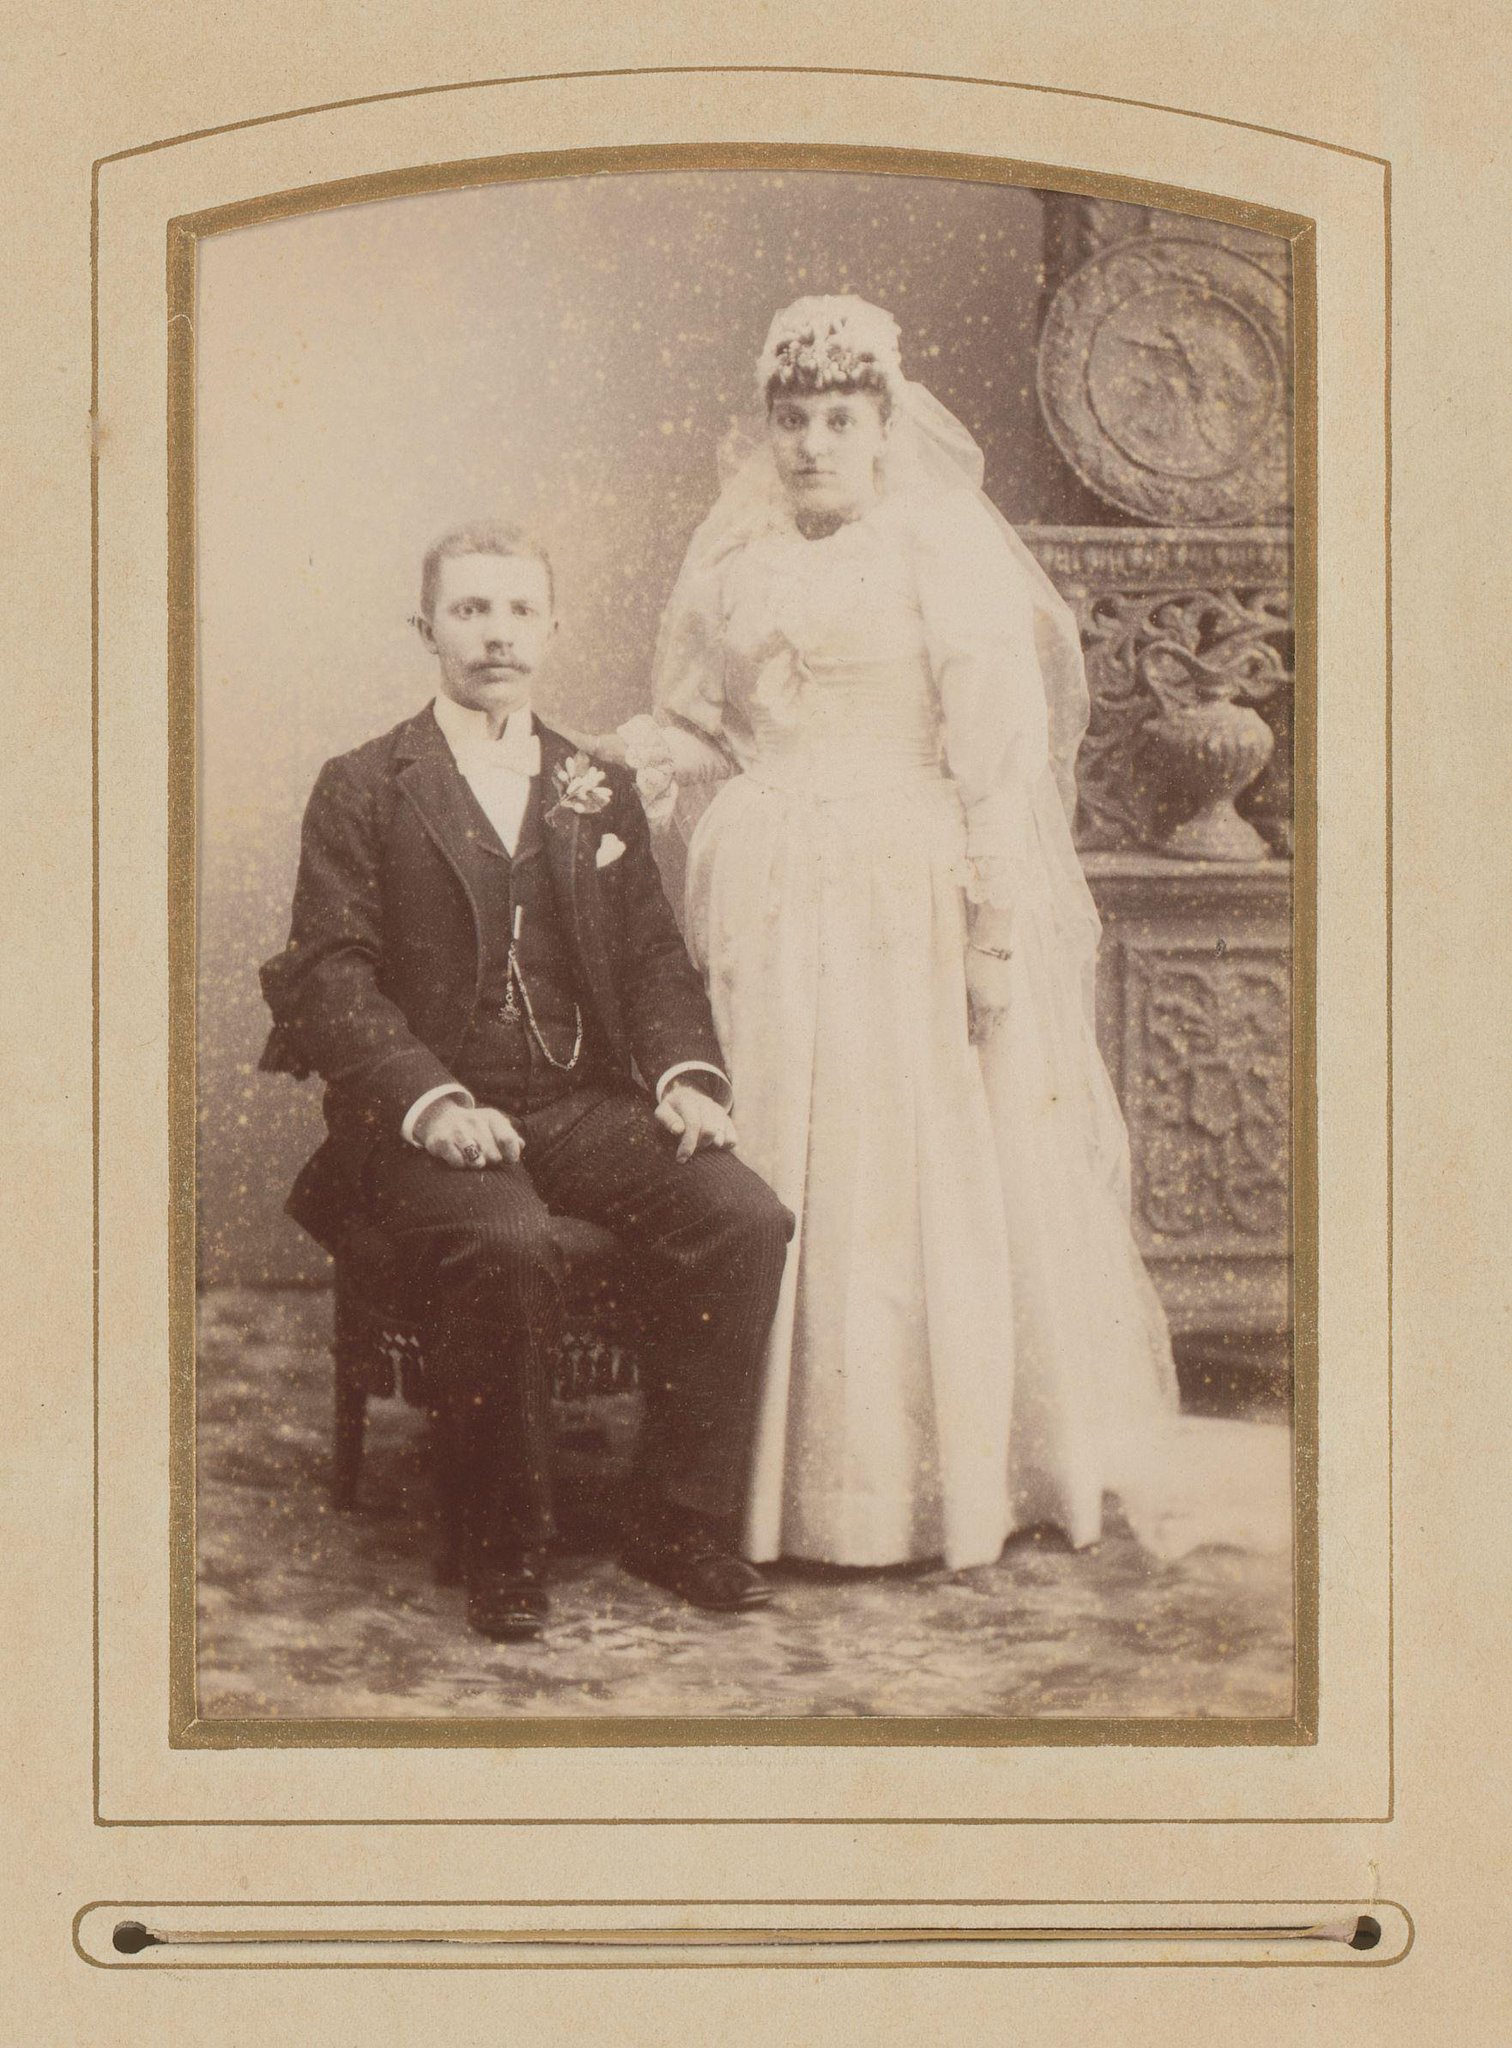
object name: cabinet photograph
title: Portret van een echtpaar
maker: a. stoffregen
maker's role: fotograaf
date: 1860-1900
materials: cardboard, photographic support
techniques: albumen print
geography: new york city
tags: historical persons - bb - woman, historical persons, couple of lovers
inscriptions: inscription: ‘A. Stoffregen/ 740 & 742 Broadway/ cor. Flushing Ave.,/ Brooklyn, N.Y.’